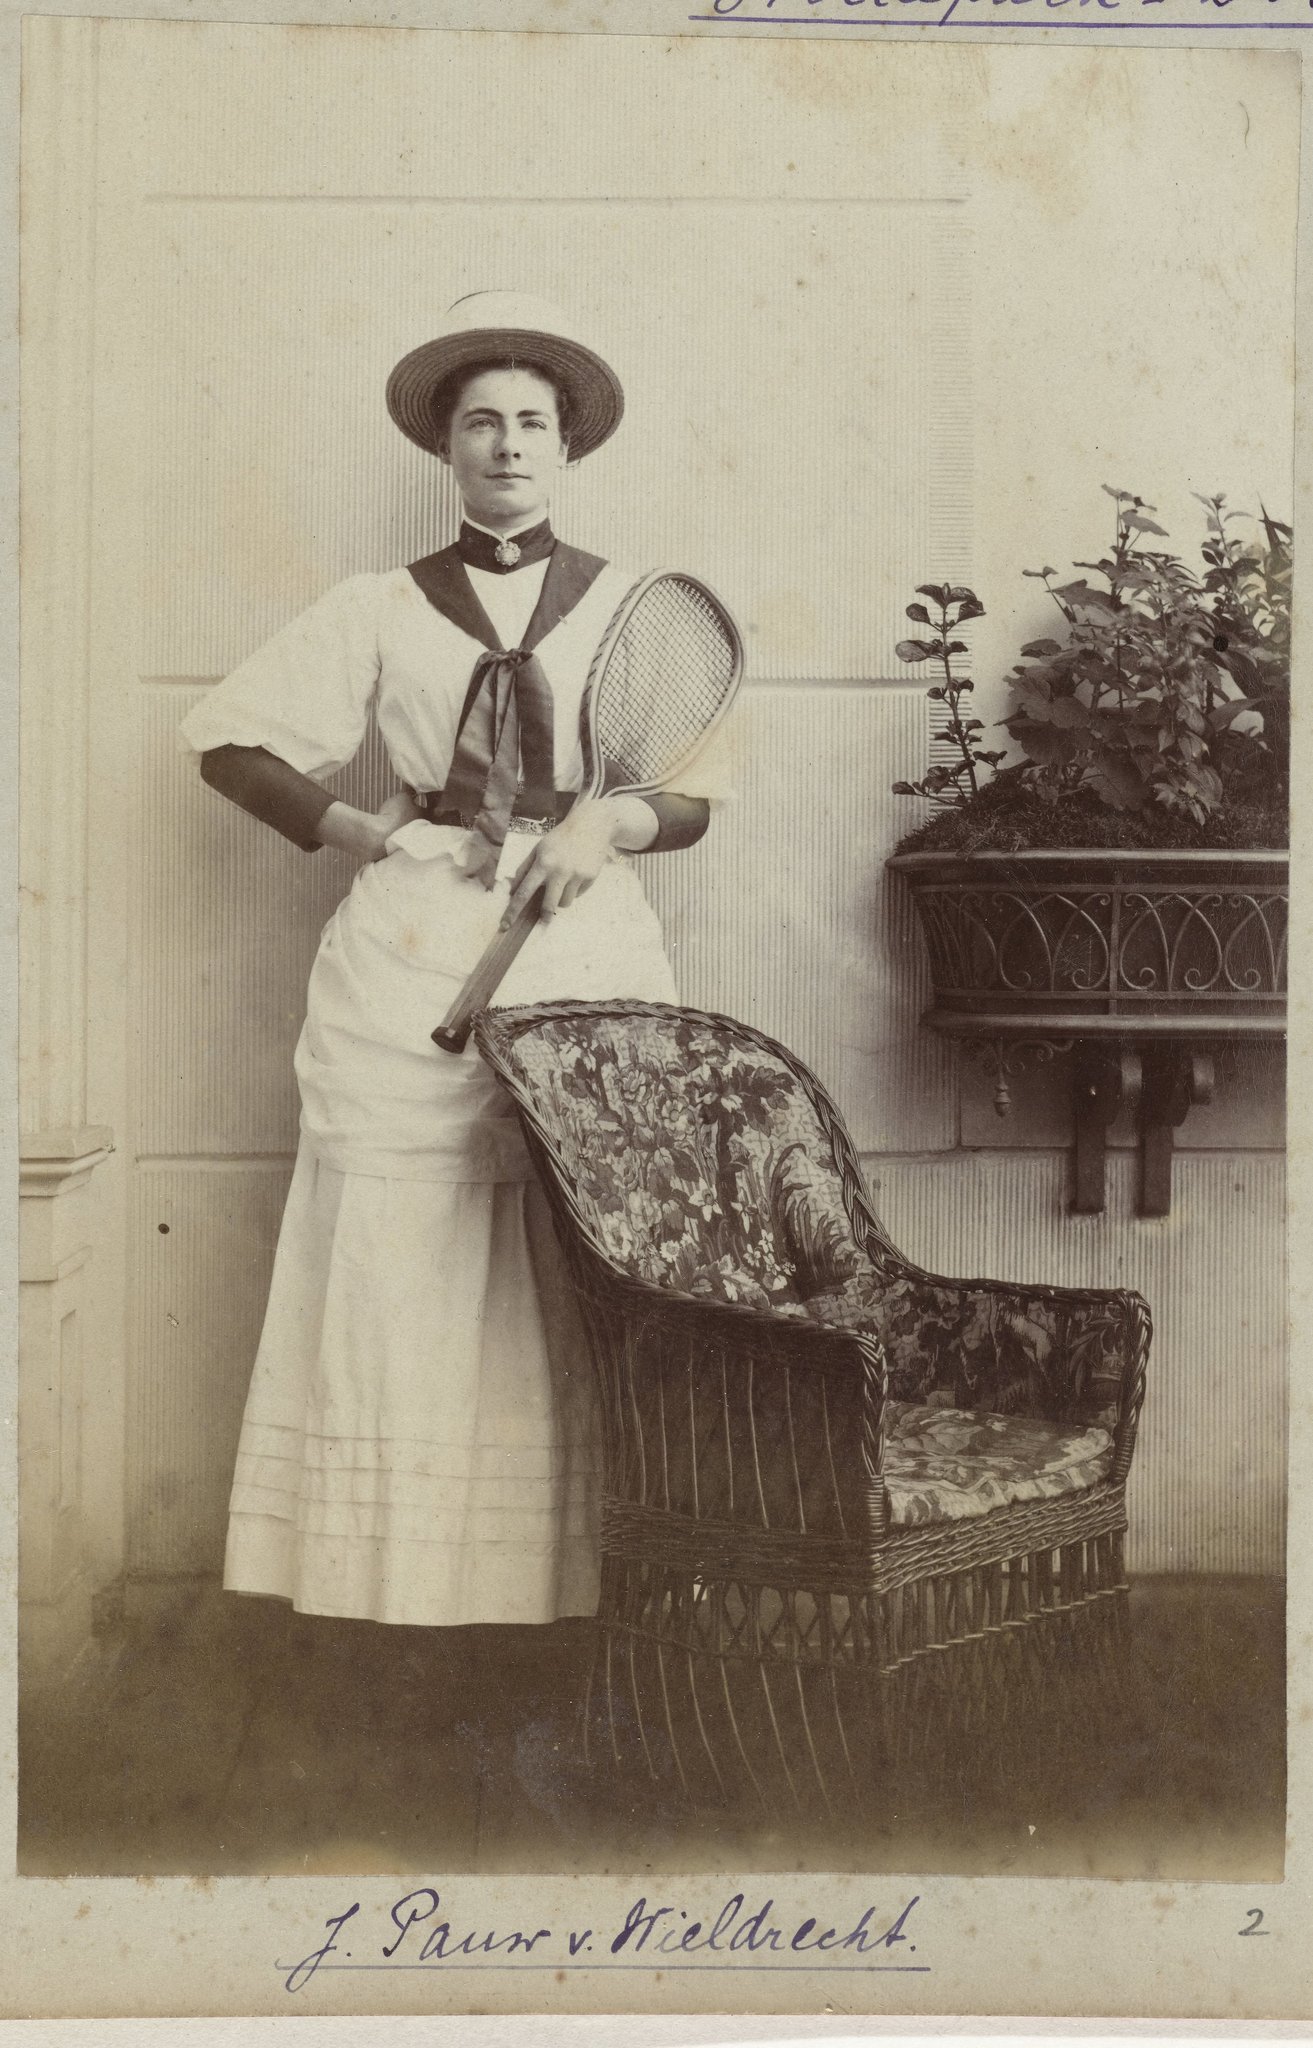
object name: photograph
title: Portret van Adriana Johanna Pauw van Wieldrecht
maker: henry pauw van wieldrecht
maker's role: fotograaf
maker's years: 1863-1912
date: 1888-1889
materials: paper, photographic support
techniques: albumen print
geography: netherlands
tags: zeist, adriana johanna pauw van wieldrecht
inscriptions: title: ‘J. Pauw v. Wieldrecht’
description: Portret van Adriana Johanna (‘Jen’ of ‘Jenny’) Pauw van Wieldrecht, een zuster van de fotograaf, in tenniskleding en met tennisracket. Met onderschrift: J. Pauw v. Wieldrecht.